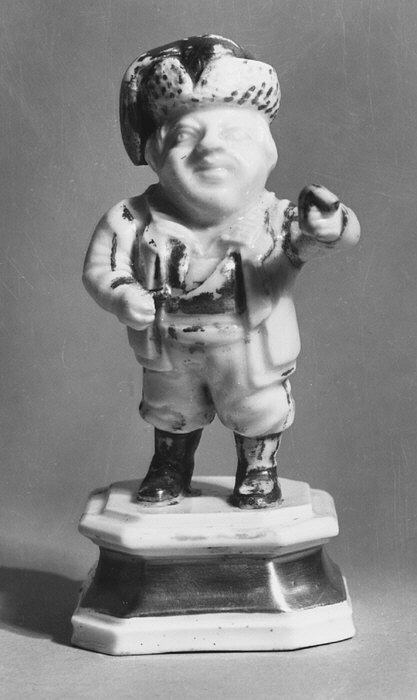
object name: figure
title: Callot dwarf (one of a pair)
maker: meissen manufactory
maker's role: manufactory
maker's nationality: german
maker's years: 1710-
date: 1720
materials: hard paste porcelain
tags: men